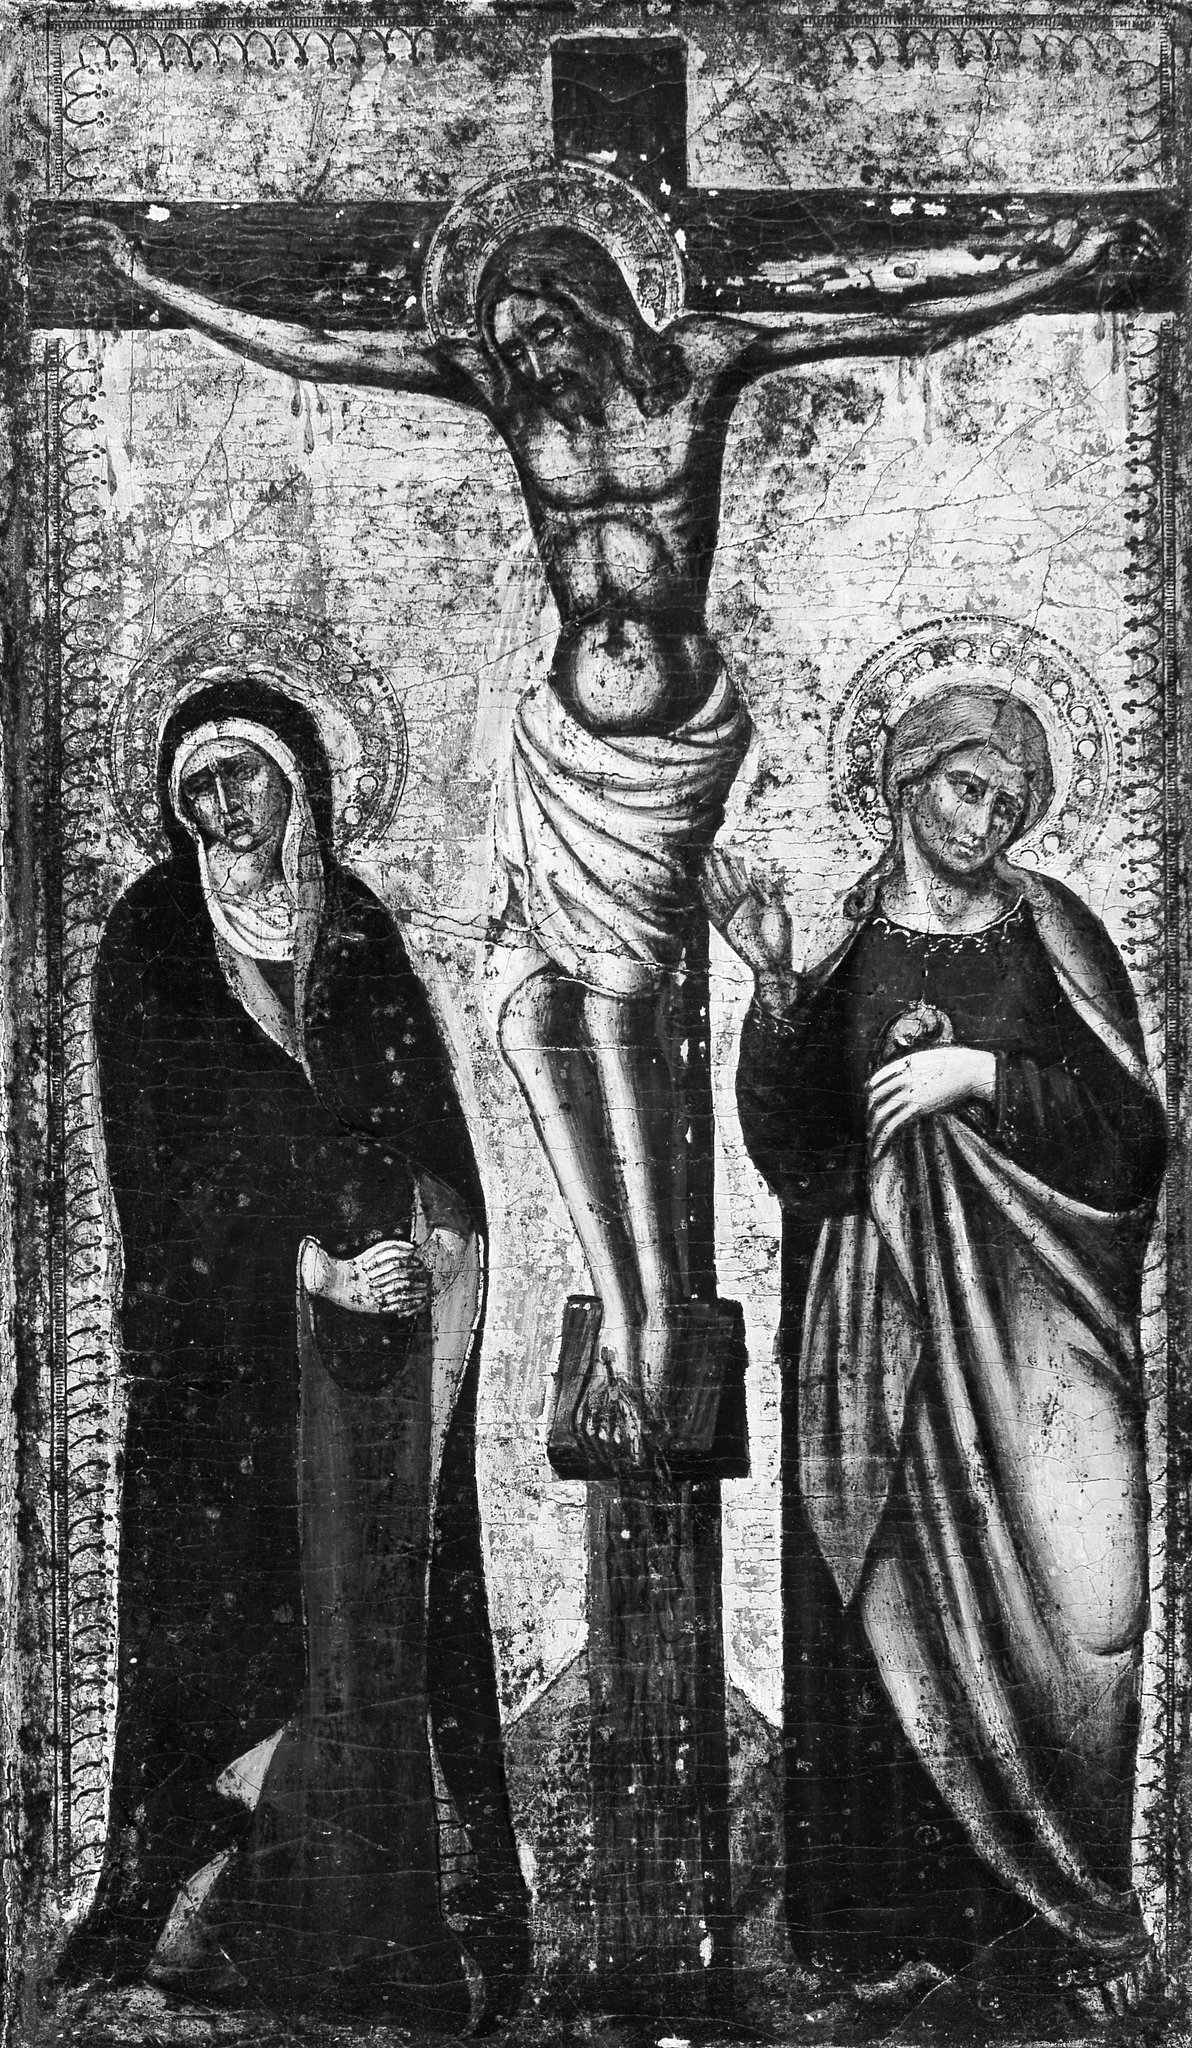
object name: painting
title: The Crucifixion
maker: luca di tommè di nuto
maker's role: artist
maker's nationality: italian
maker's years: 1356-1389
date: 1920-1925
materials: gold leaf, oil, wood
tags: christ,virgin mary,crucifixion